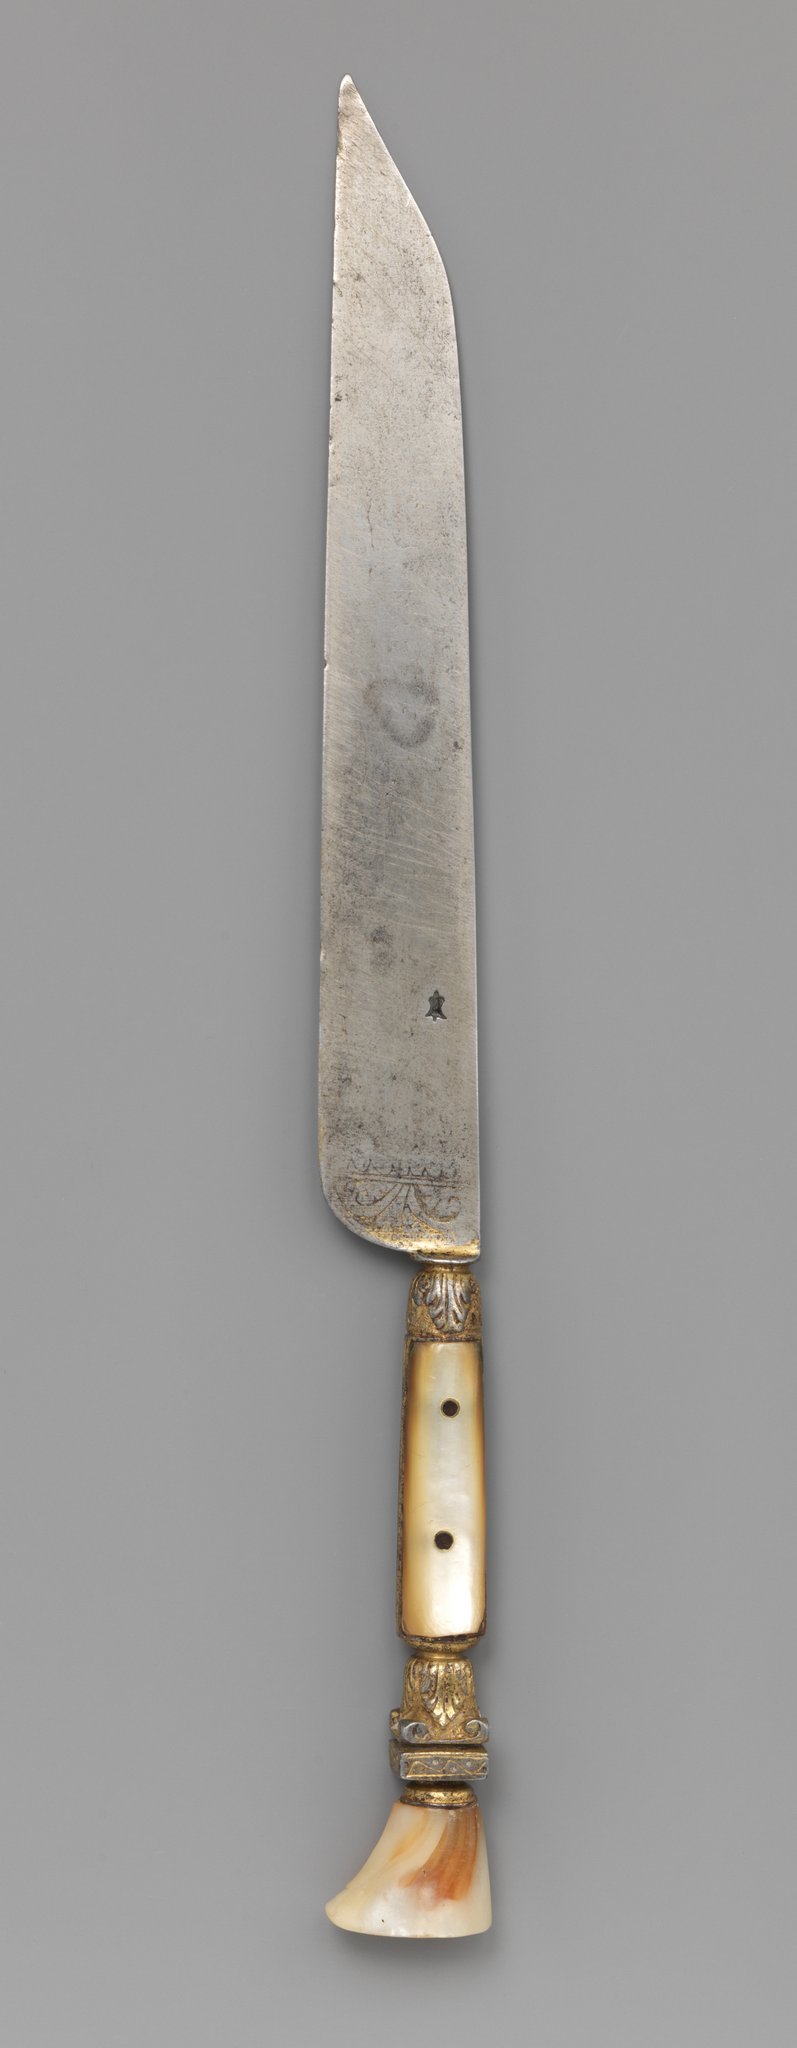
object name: table knife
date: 1567-1600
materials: gilt bronze, mother of pearl, steel